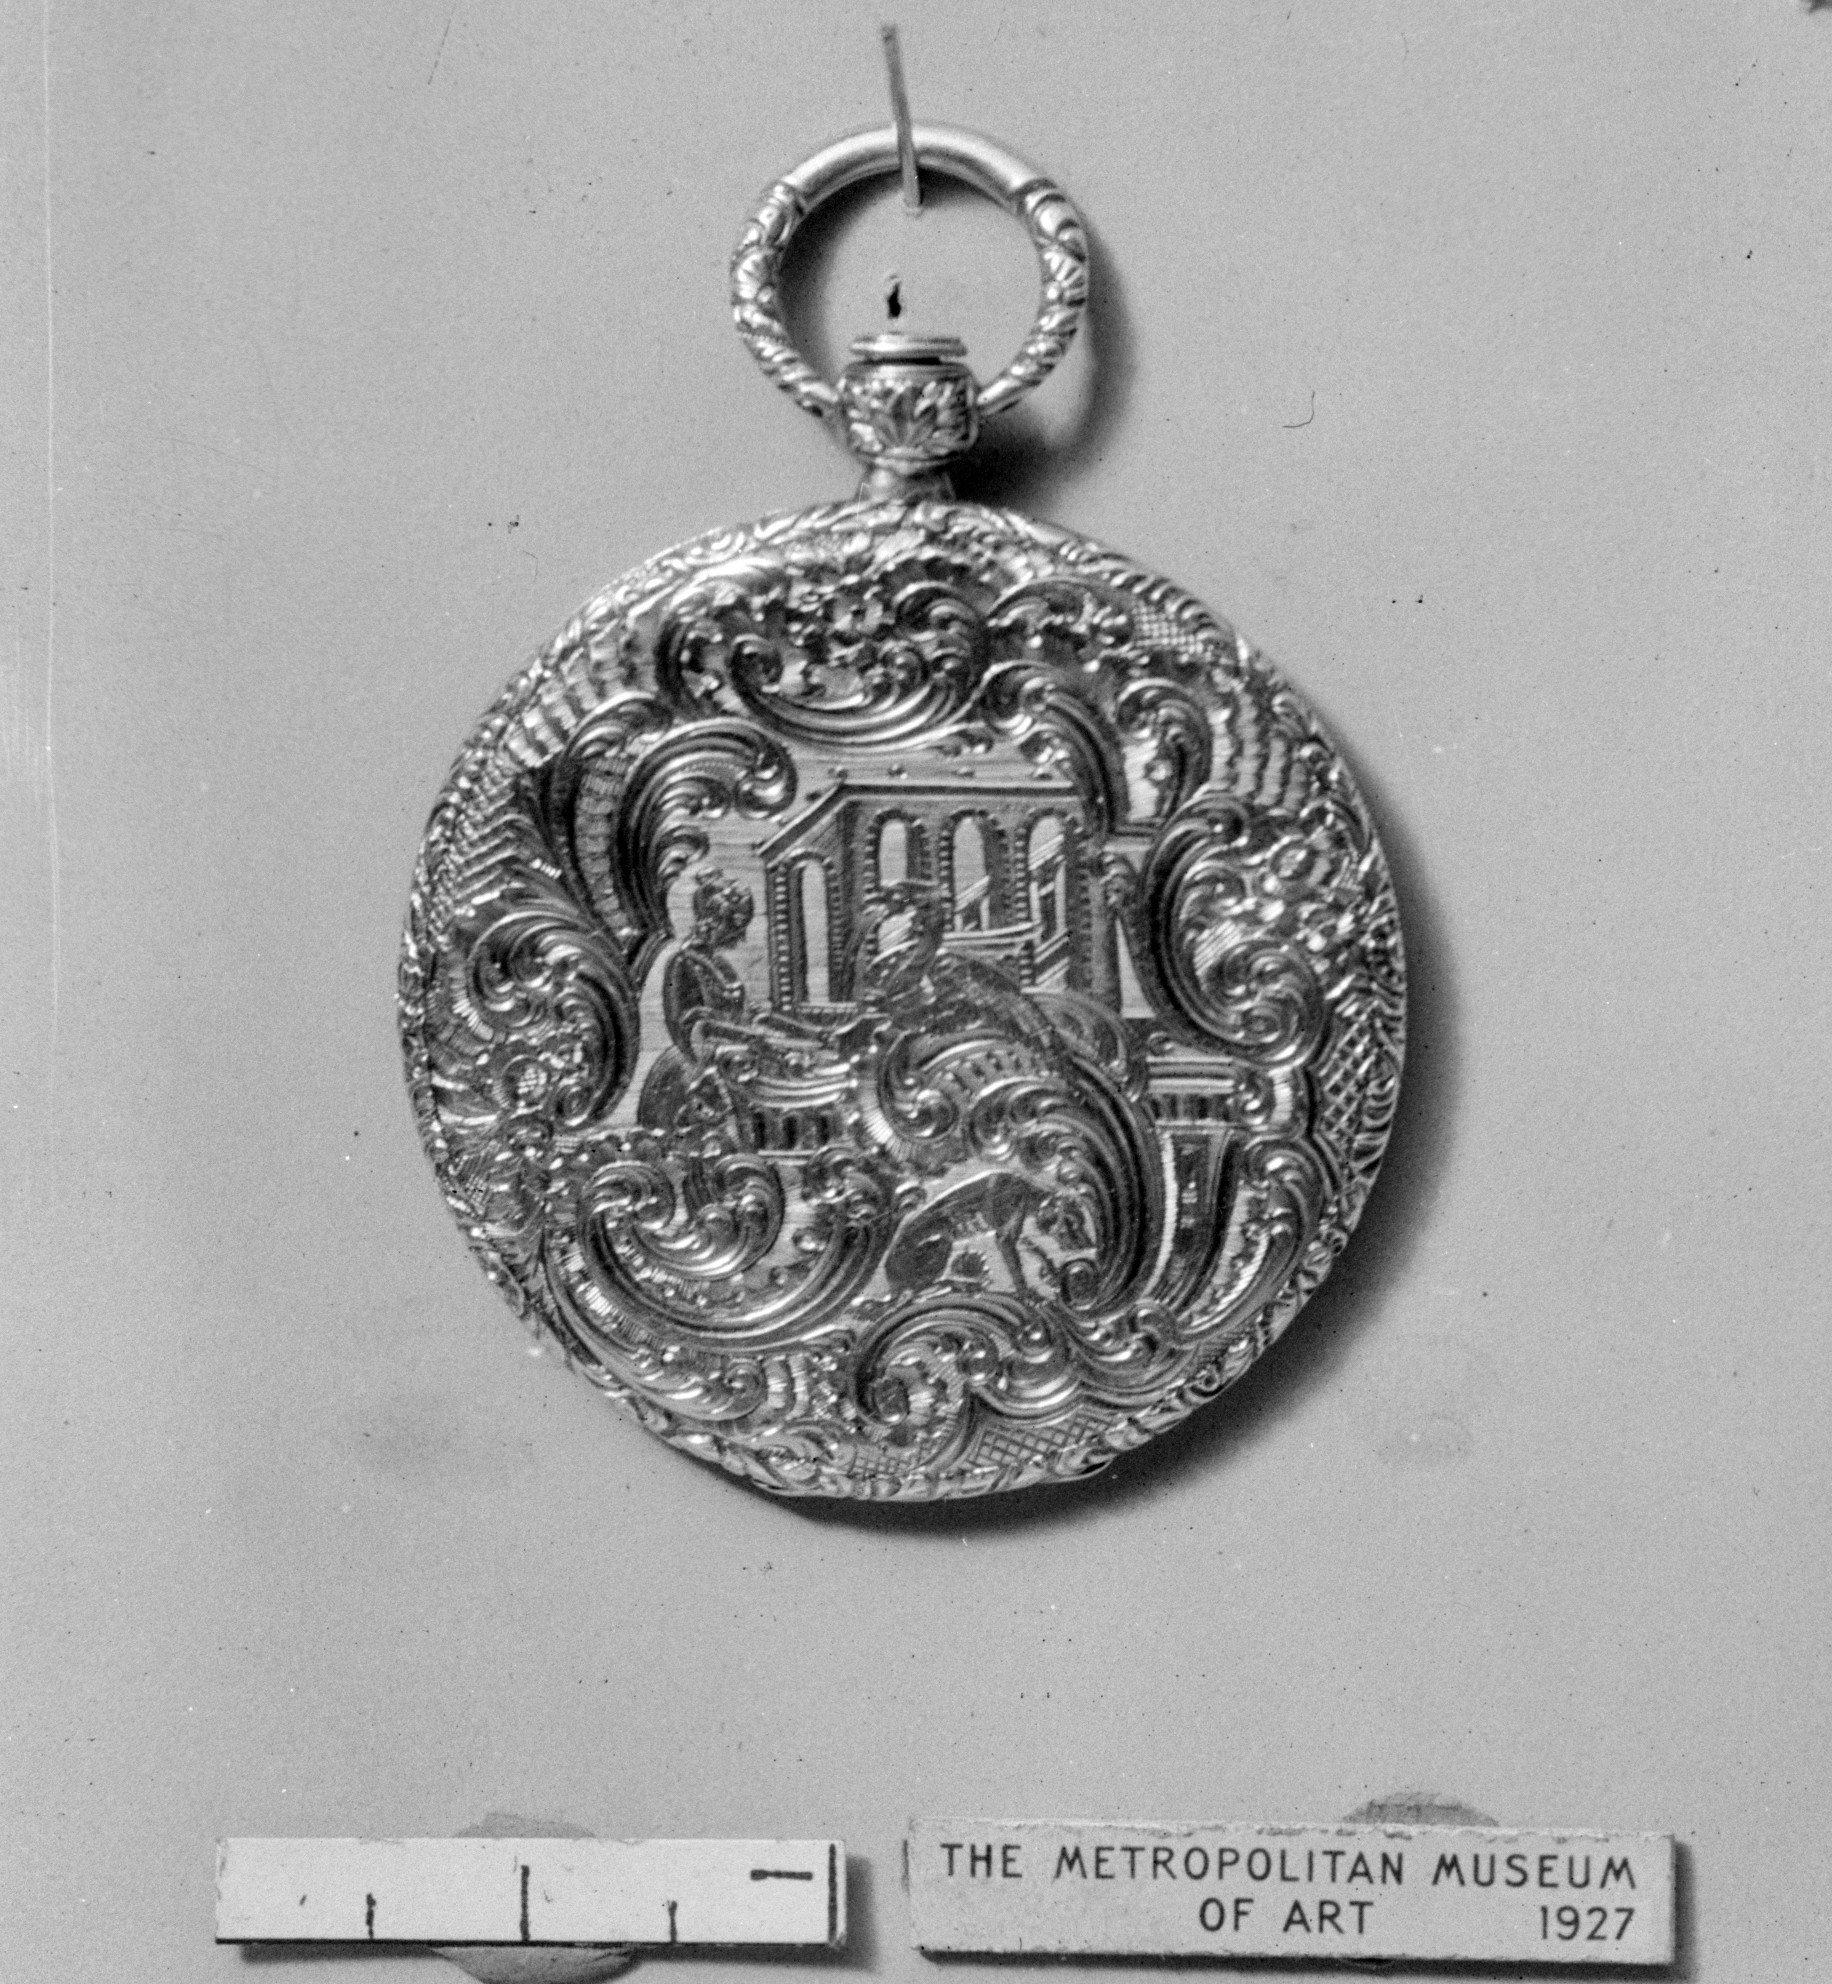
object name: watch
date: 1840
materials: crystal, gold, silver